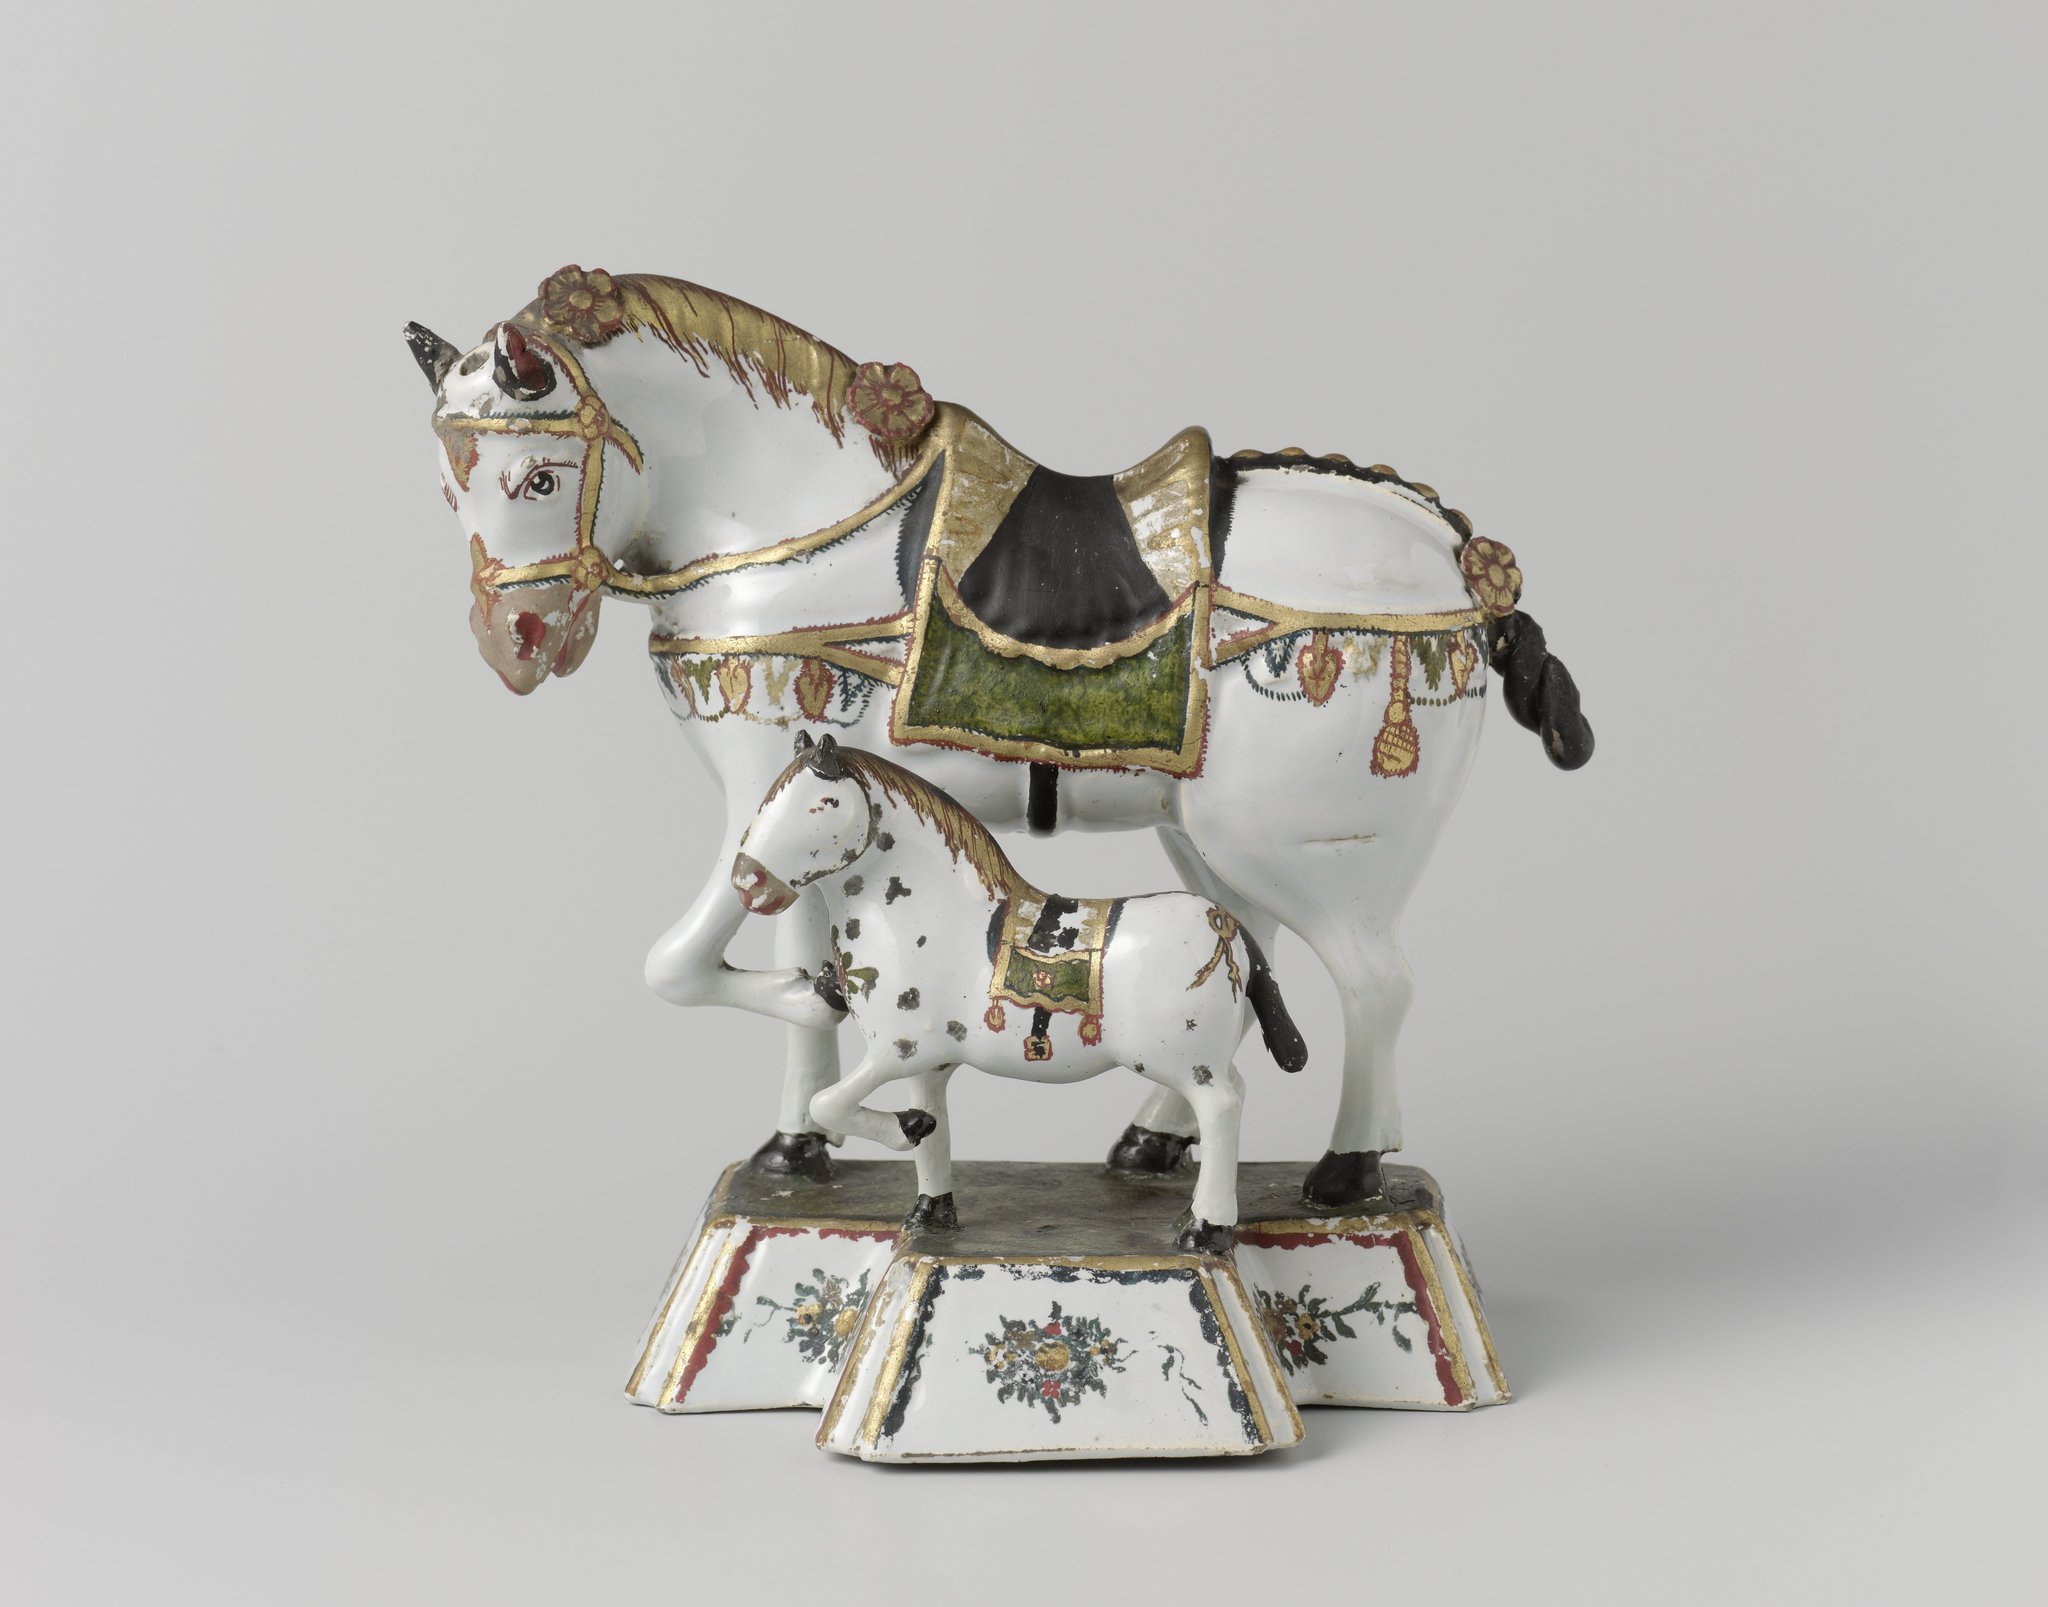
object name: figure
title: Paard met veulen, veelkleurig beschilderd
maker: Anonymous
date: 1740-1760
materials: faience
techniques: painted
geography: ansbach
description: Mare and foal. Faience, painted on the glaze after firing. Ansbach (?), (Germany), c. 1740 - 1760. Given by the heirs of John F. Loudon, 1916.